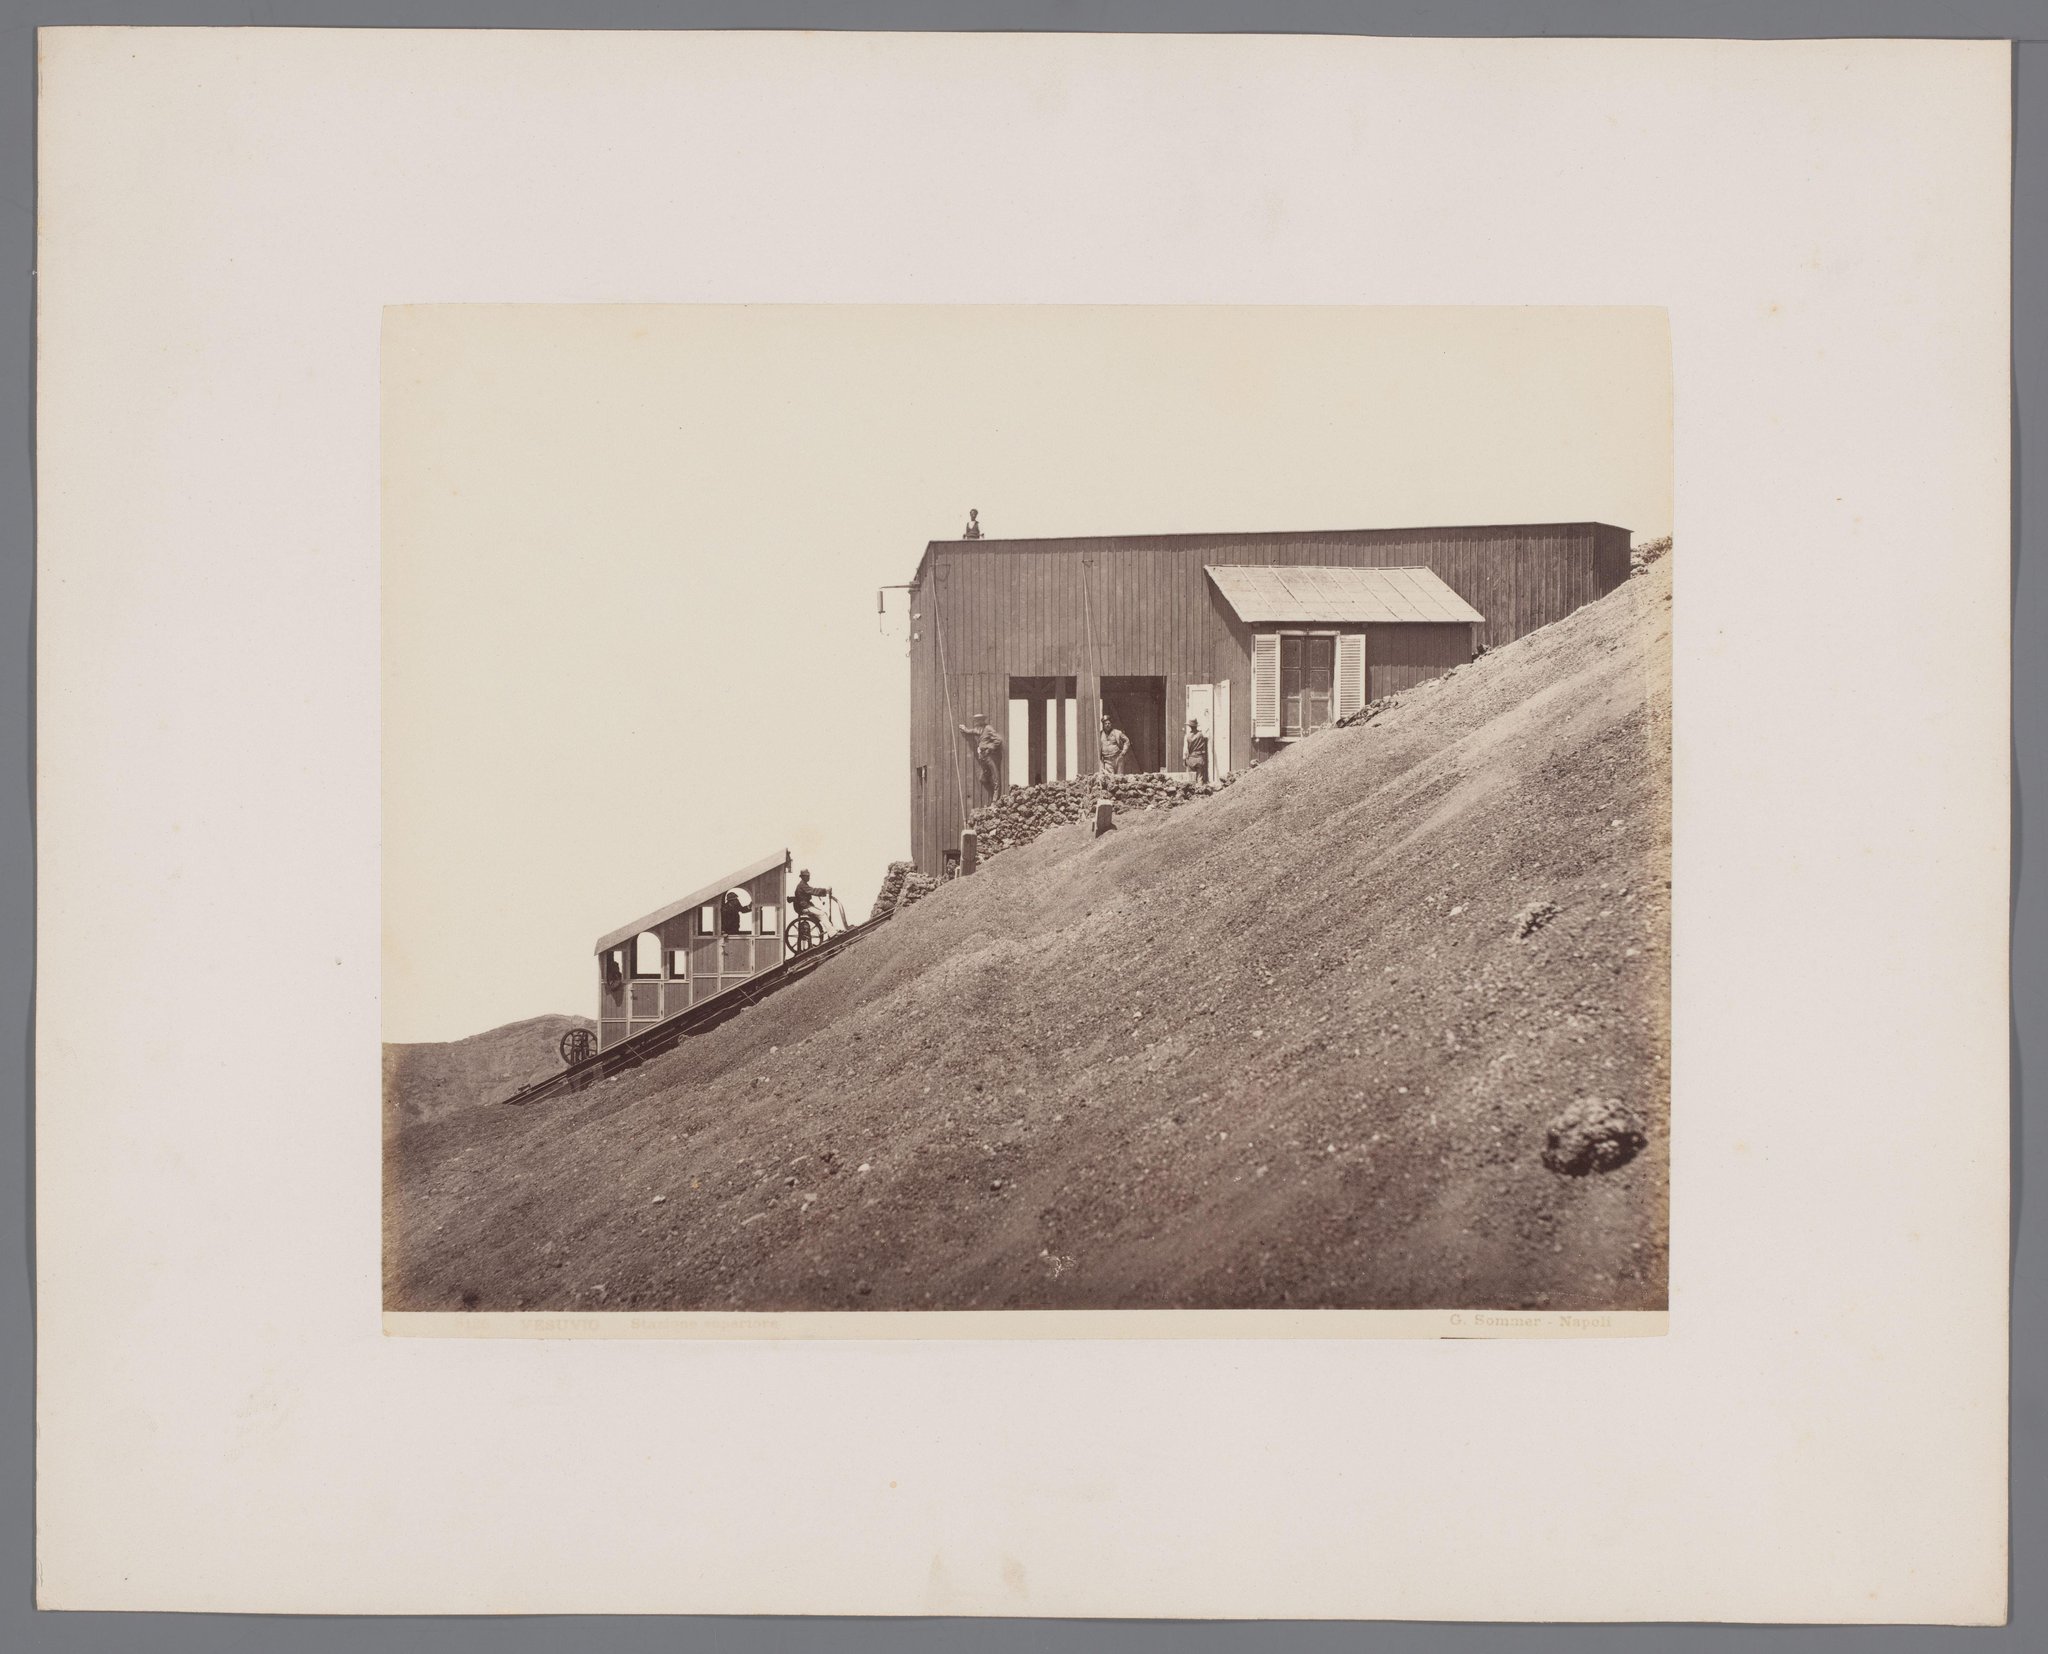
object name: photograph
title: Vesuvio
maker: giorgio sommer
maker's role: fotograaf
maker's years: 1834-1914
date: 1857-1914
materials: cardboard, paper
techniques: albumen print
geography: mount vesuvius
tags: rack railway, volcano, mount vesuvius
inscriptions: number: ‘8125’